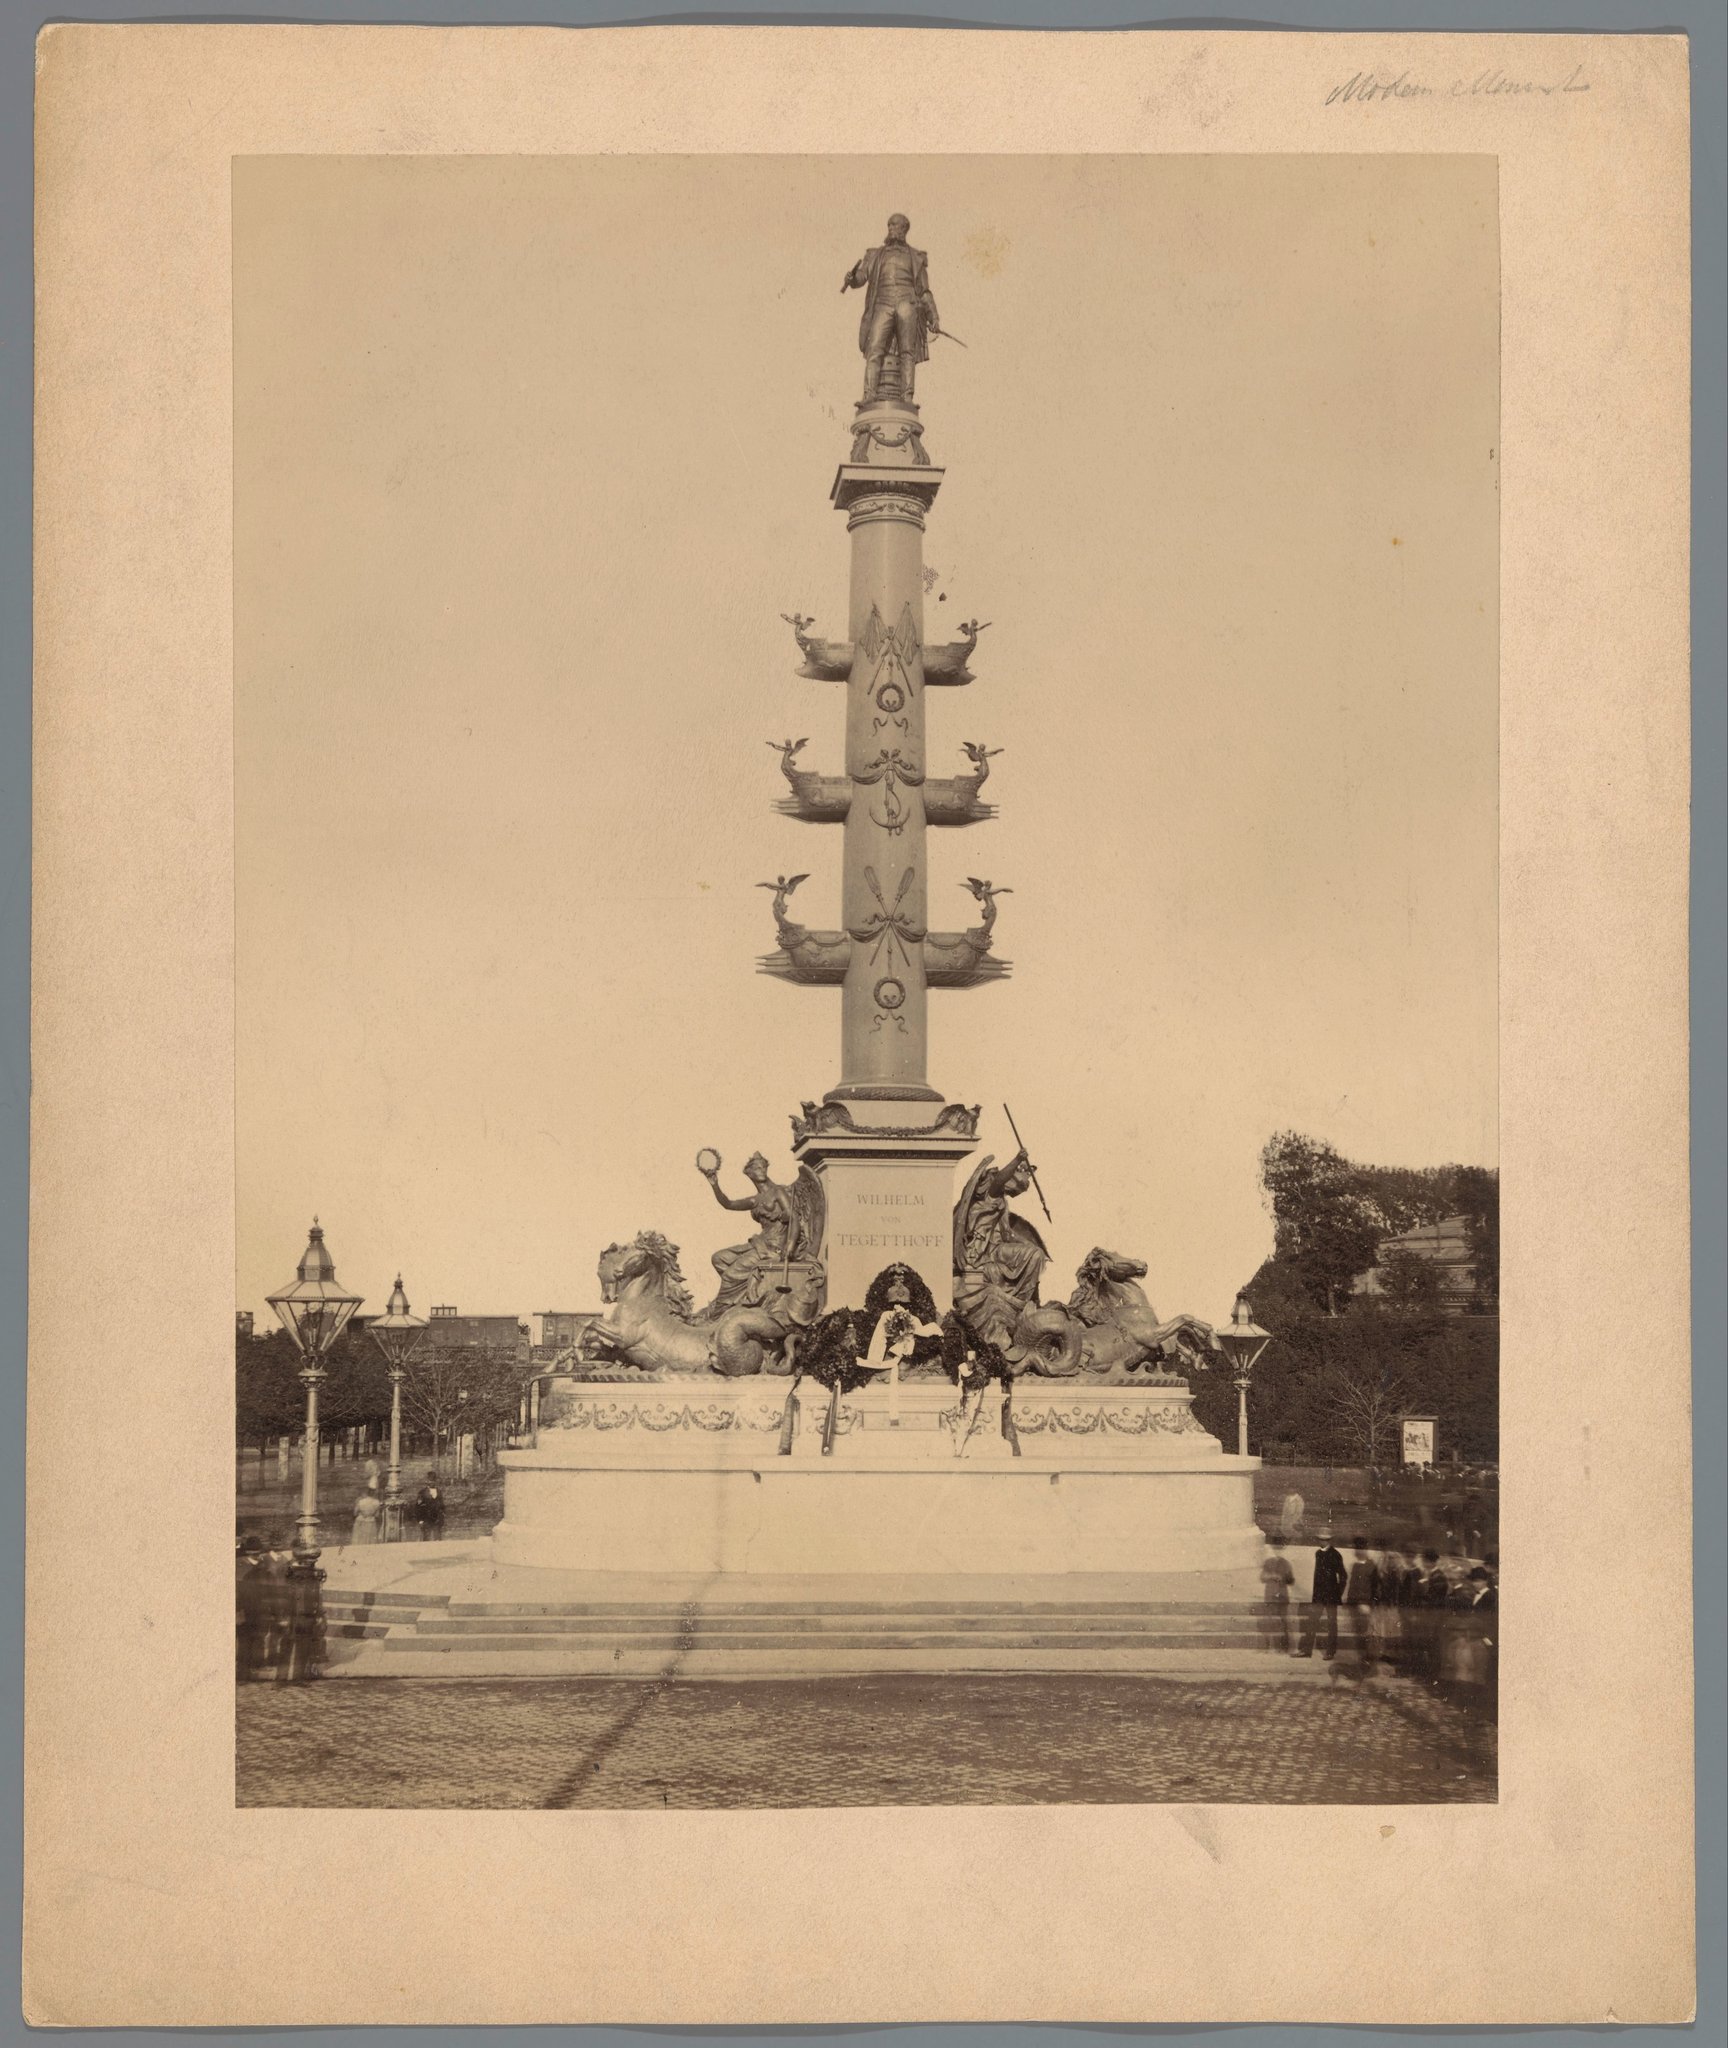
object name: photograph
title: Monument voor admiraal Wilhelm von Tegetthoff te Wenen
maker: a.f. ozihak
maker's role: fotograaf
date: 1875-1900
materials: cardboard, photographic support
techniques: albumen print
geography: munich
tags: column, pillar ~ architecture, monument, statue, sculpture, vienna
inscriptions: inscription: ‘Modern M[..]’, inscription: ‘Wien. Tegethoff - monument.’, inscription: ‘XI pl 9’, collector's mark: Lugt 3937, name: ‘J. A. G. DE LEUR Représantant Huigenspark 40b DEN HAAG.’